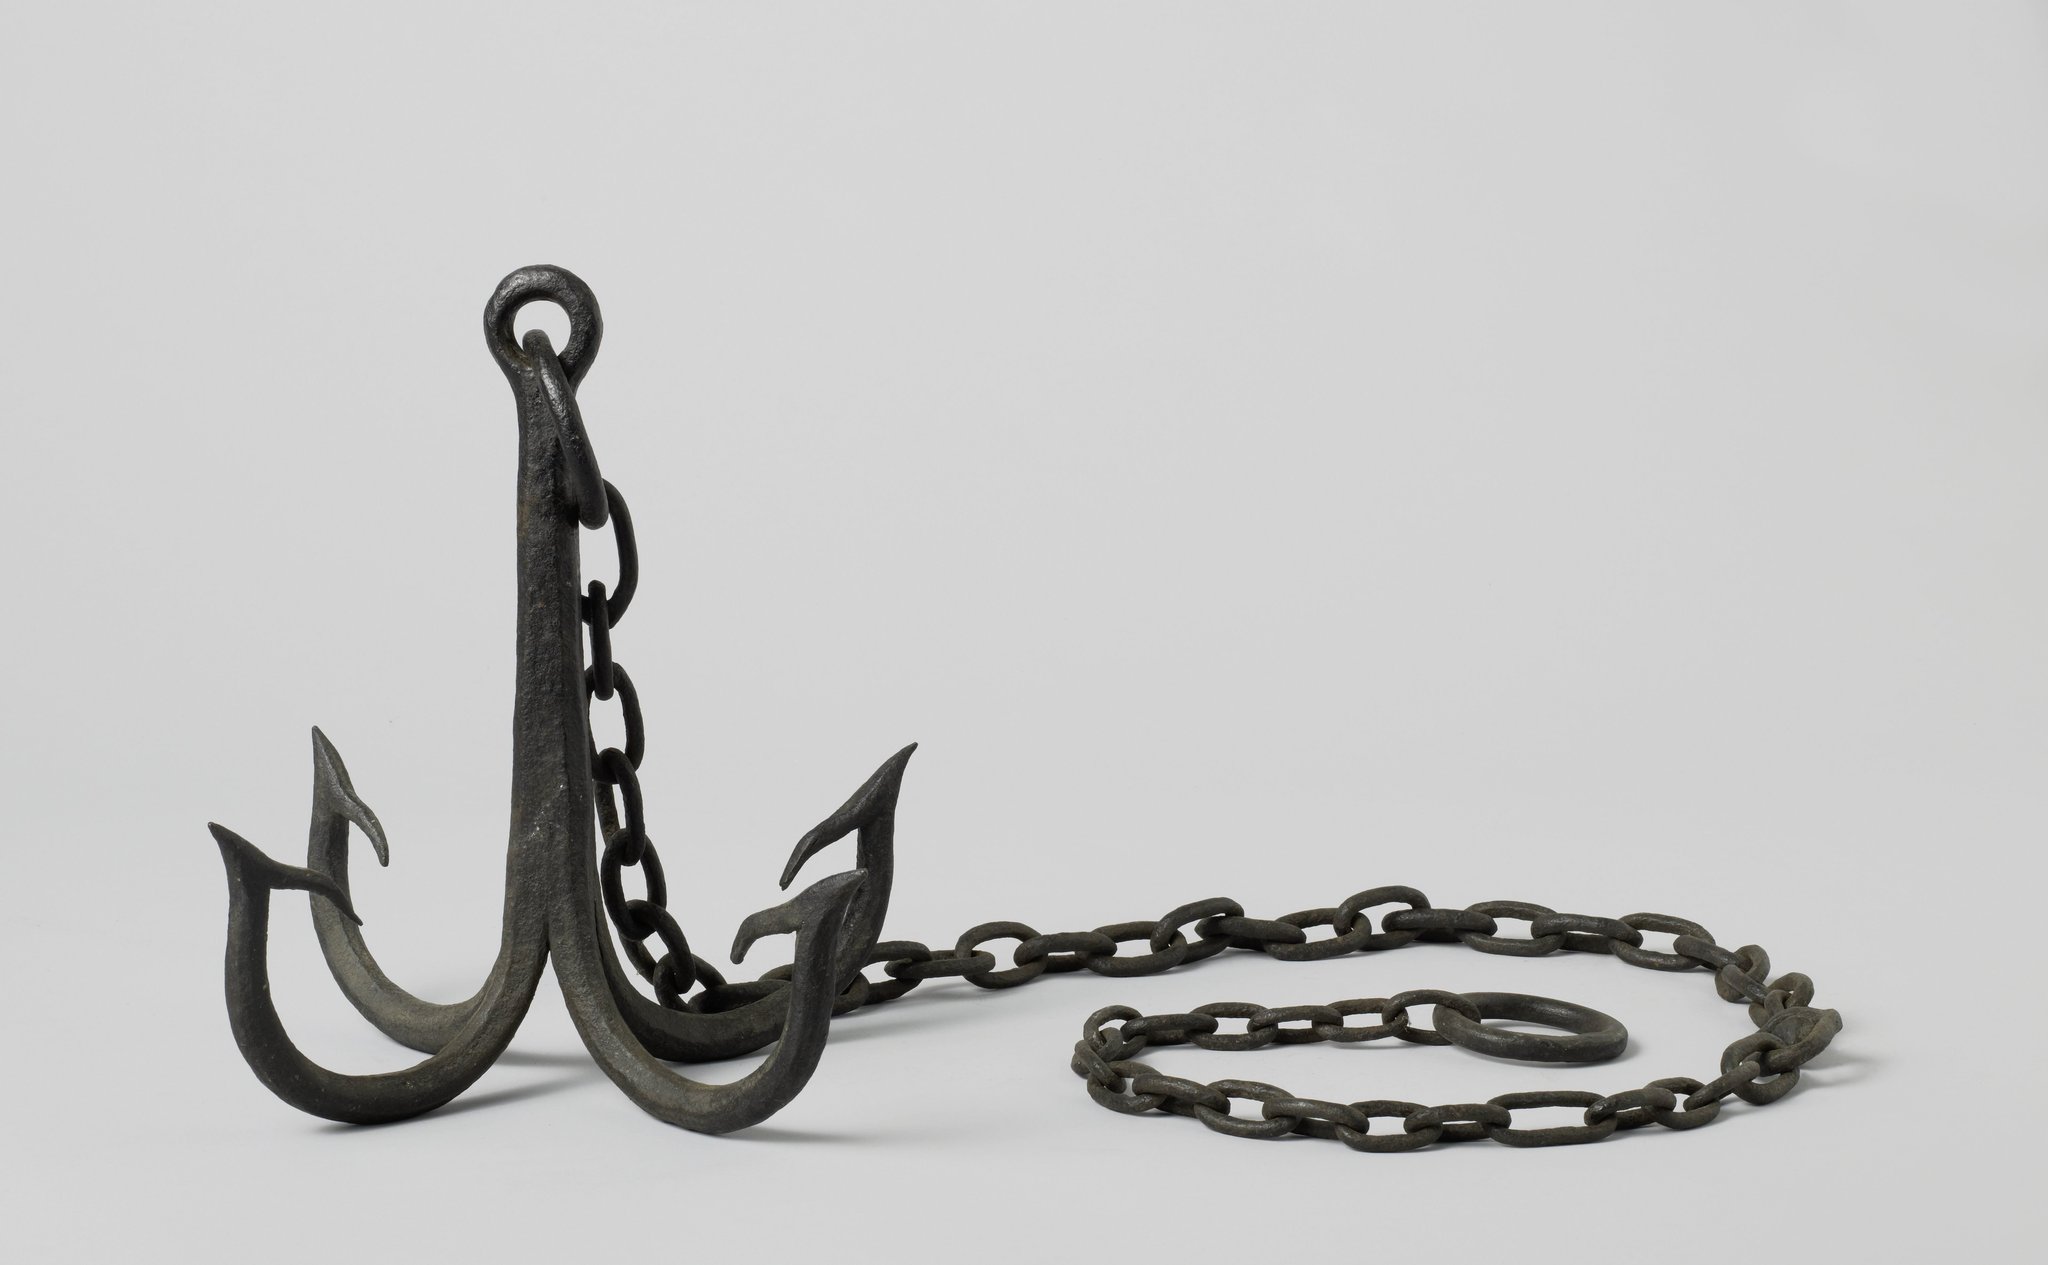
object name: dredger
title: Boarding Grapnel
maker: Anonymous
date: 1800-1850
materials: iron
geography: netherlands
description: Vierarmige dreg met een ring aan de top van de schacht en een ketting; de armen hebben geen handen maar weerhaken.